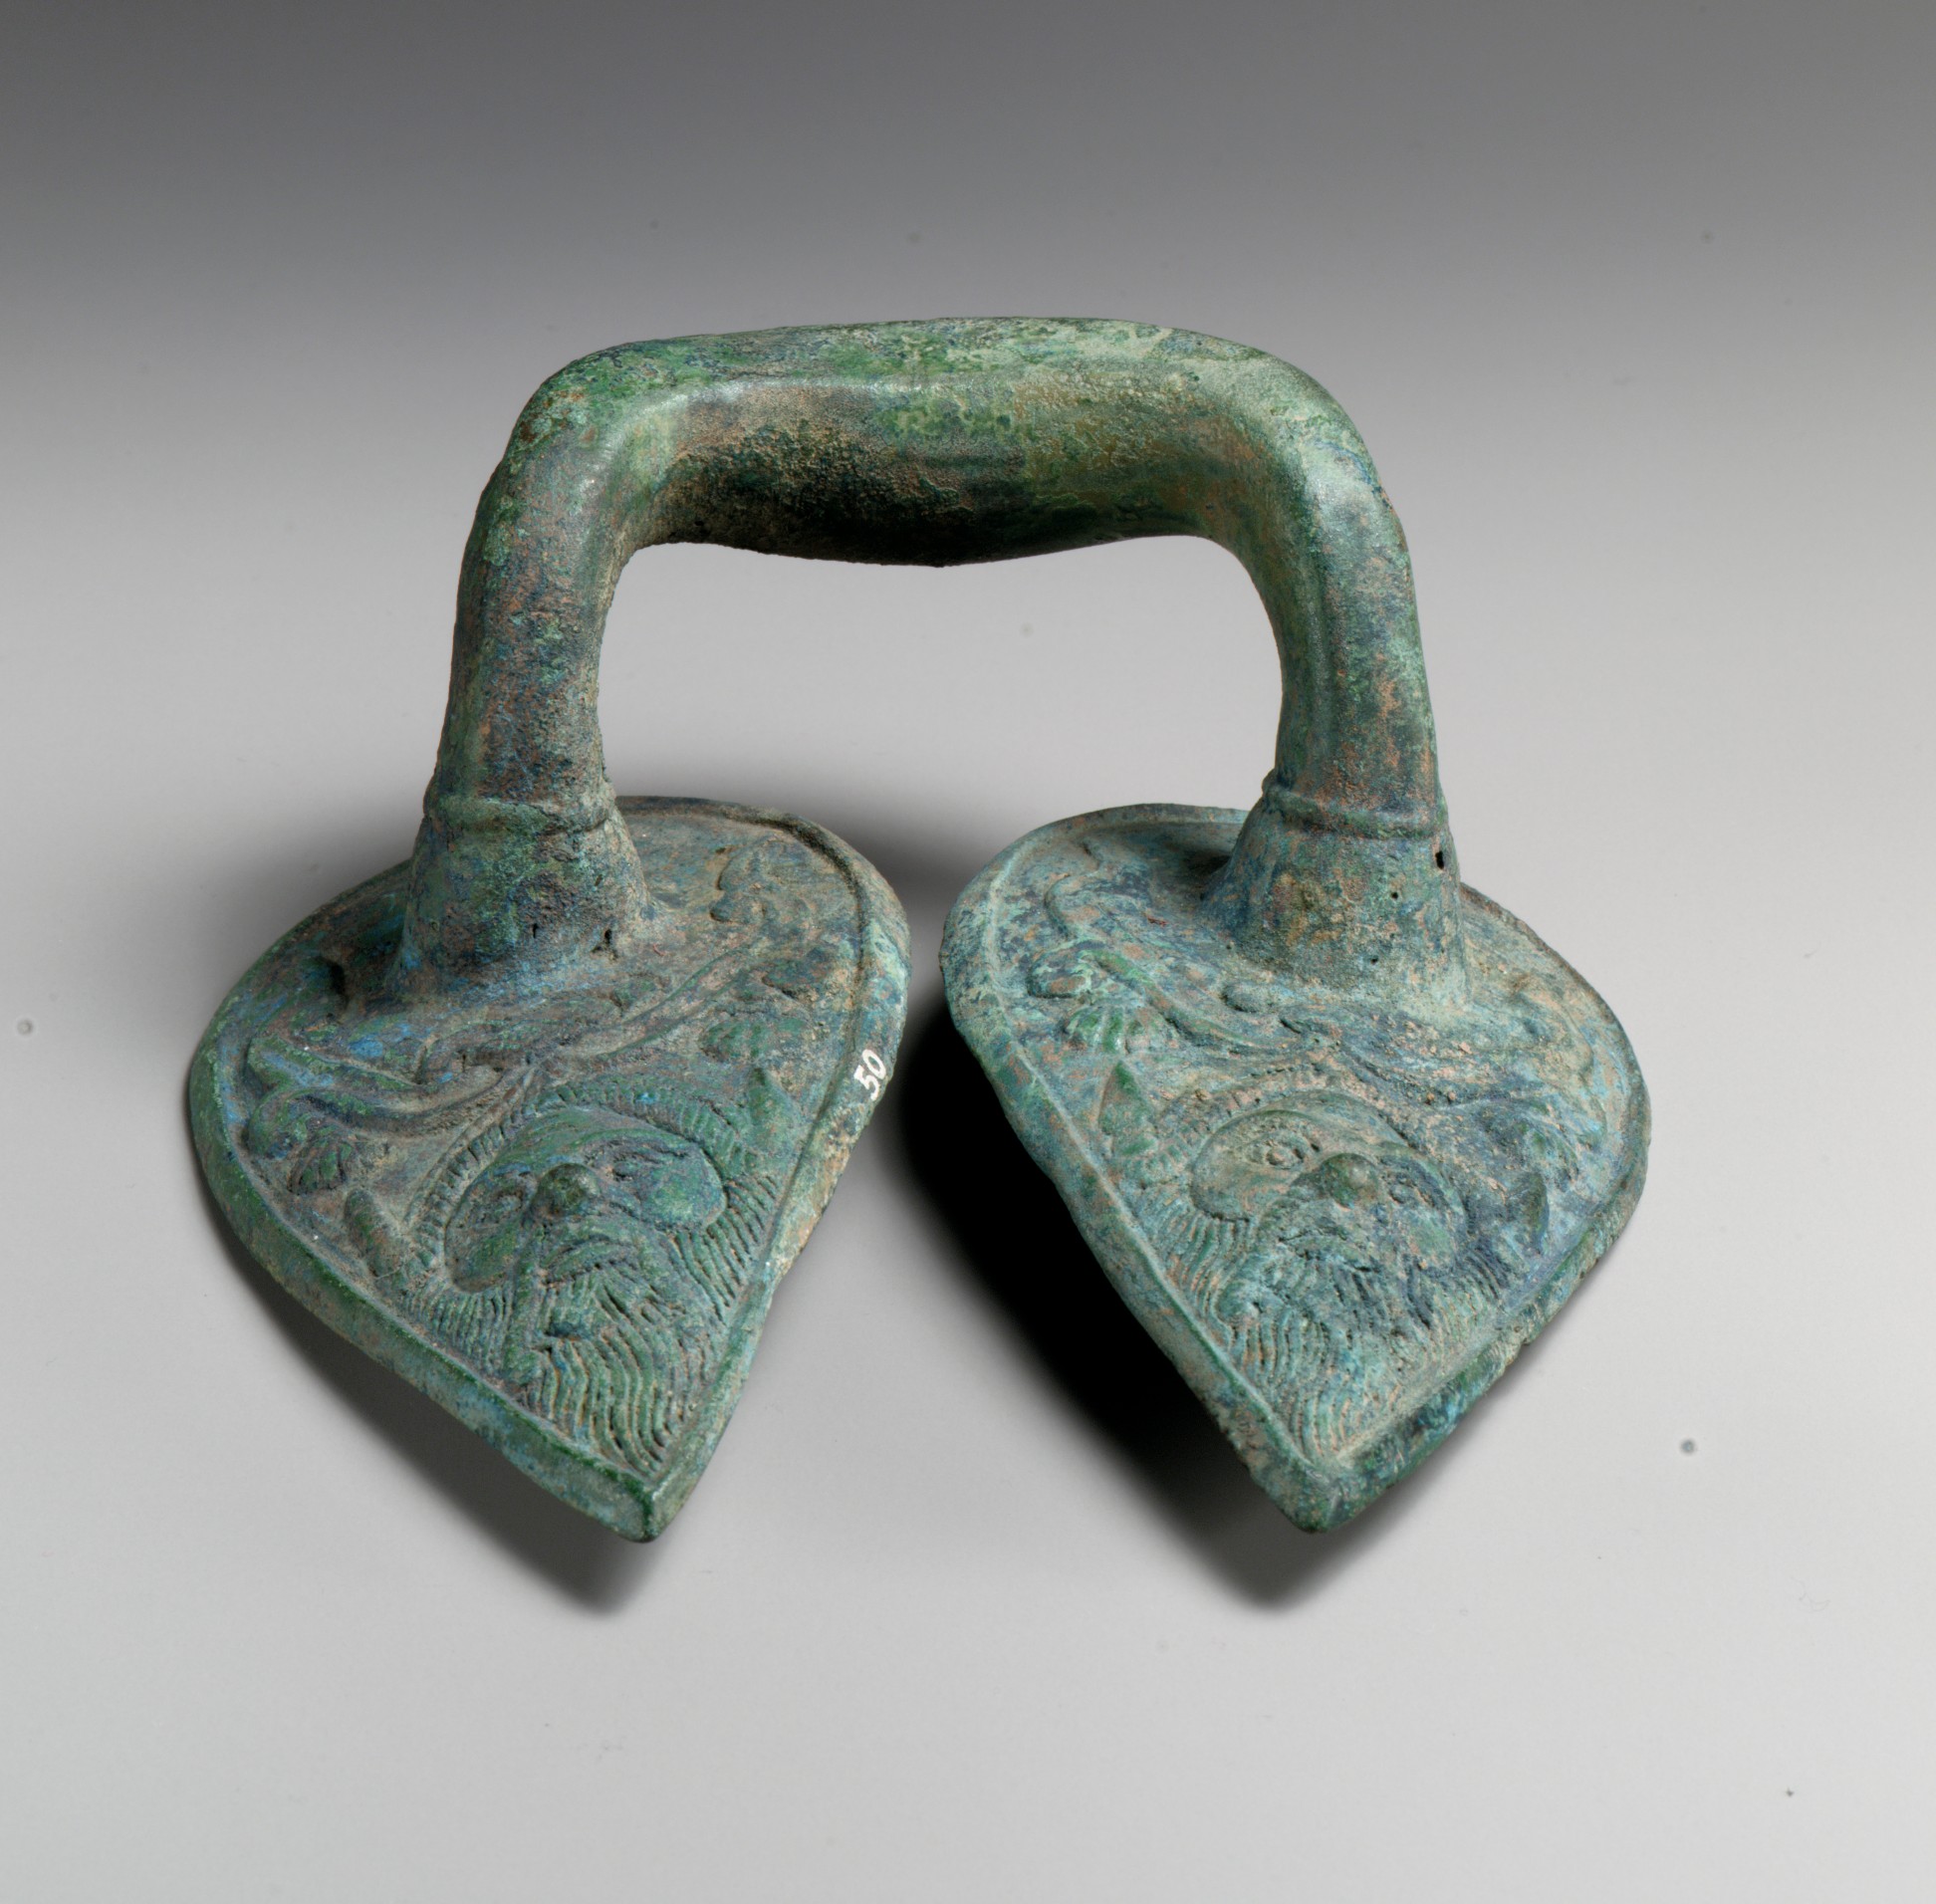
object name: handle with silenos mask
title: Bronze handle of a vessel with Silenos mask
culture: etruscan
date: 450-400 BCE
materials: bronze